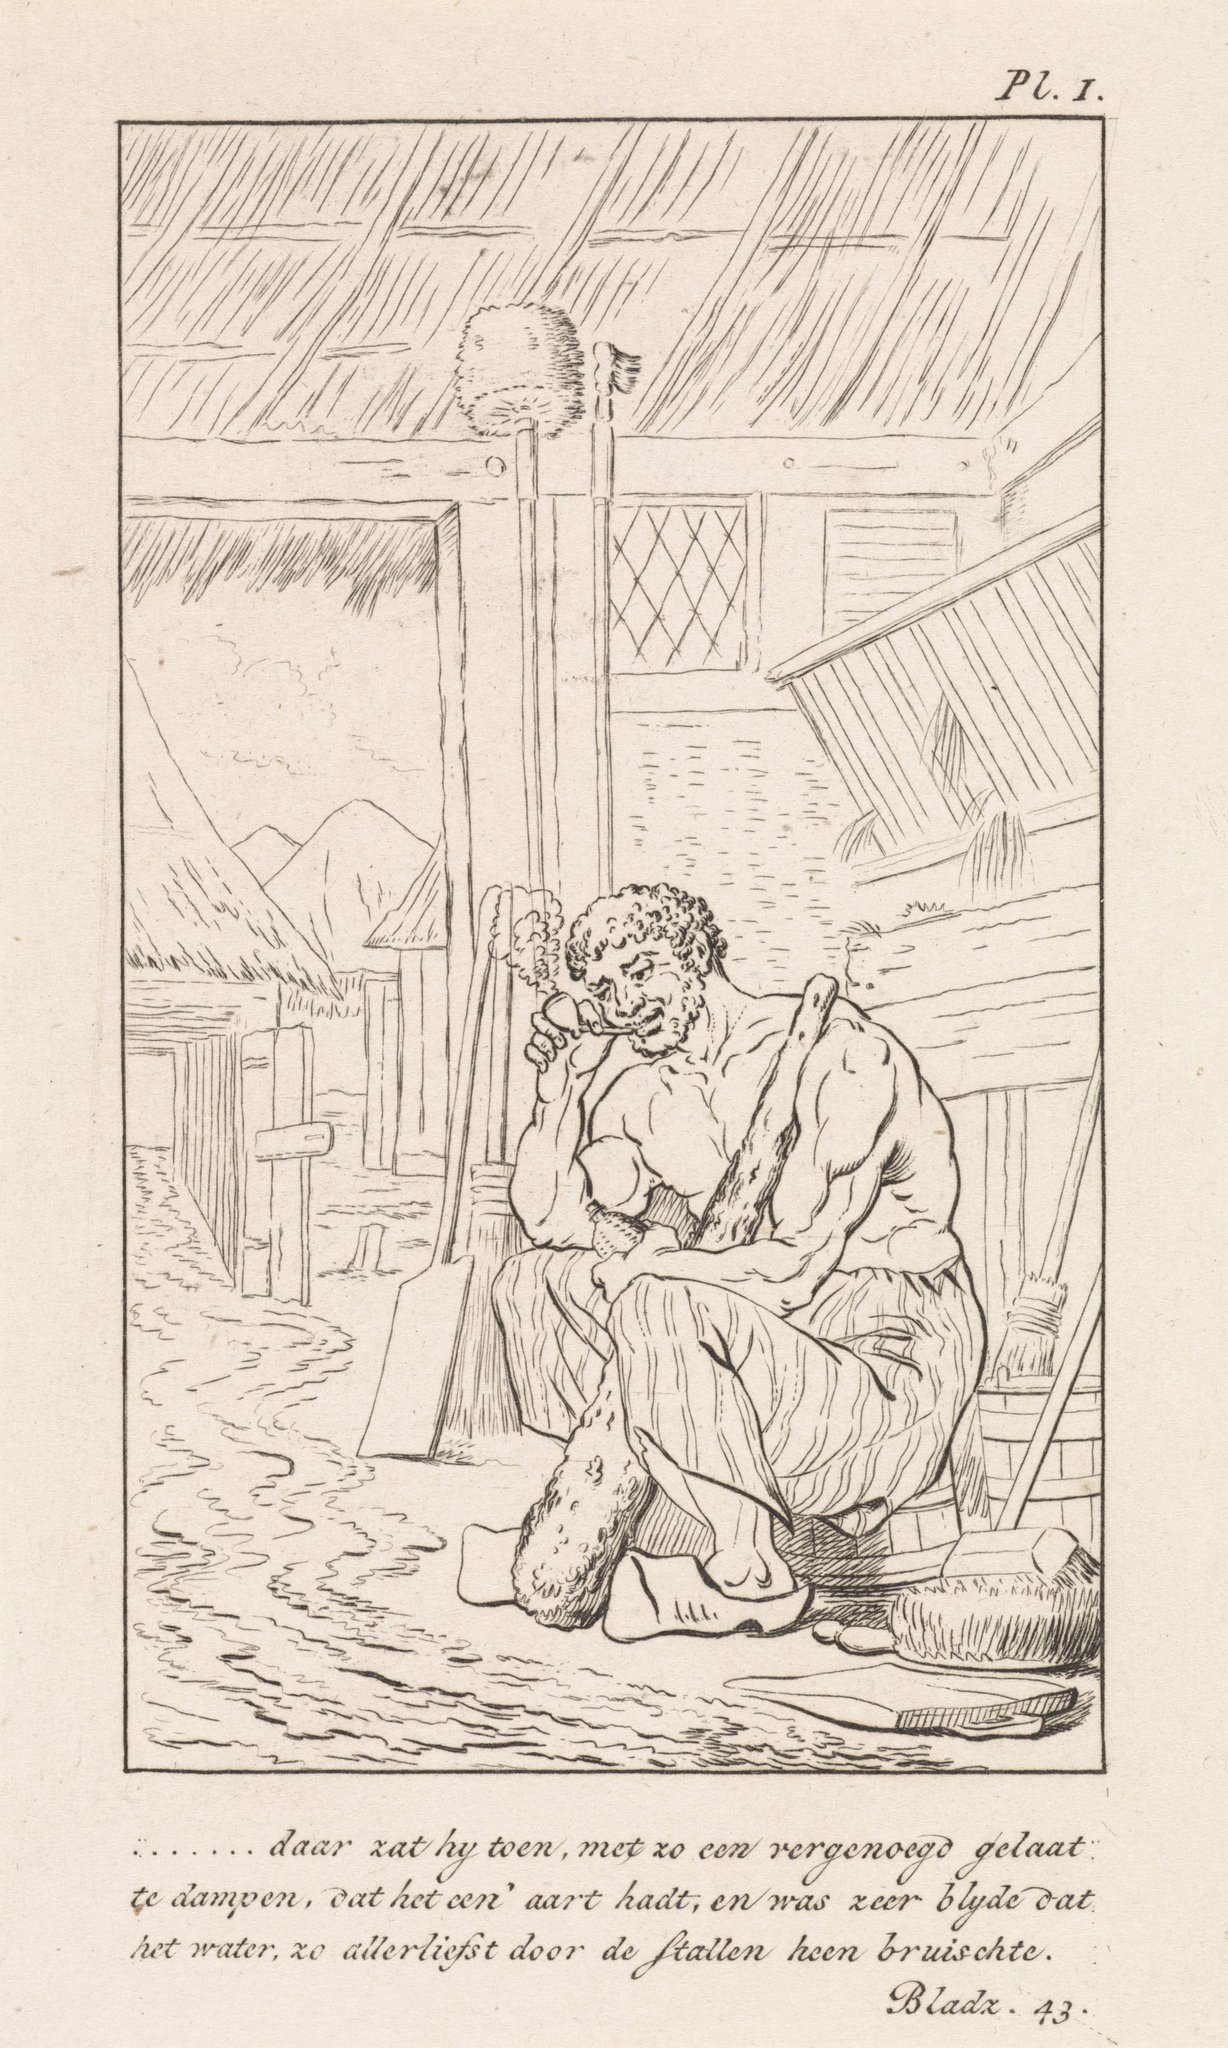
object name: print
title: (...).. Daar zat hij toen, met zo een vergenoegd gelaat (...) door de stallen heen bruischte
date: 1802-1809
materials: paper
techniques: etching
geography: haarlem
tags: pipe ~ tobacco, stall, stable, weapons for striking a blow: club, political caricatures and satires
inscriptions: collector's mark: Lugt 2228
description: Prent als boekillustratie gebruikt in: Fokke Simonsz., Arend. London in een' boertigen stijl beschreeven. Deel III uit: Boertige Reis door Europa. 7 dln. Haarlem: François Bohn, 1802-1809.